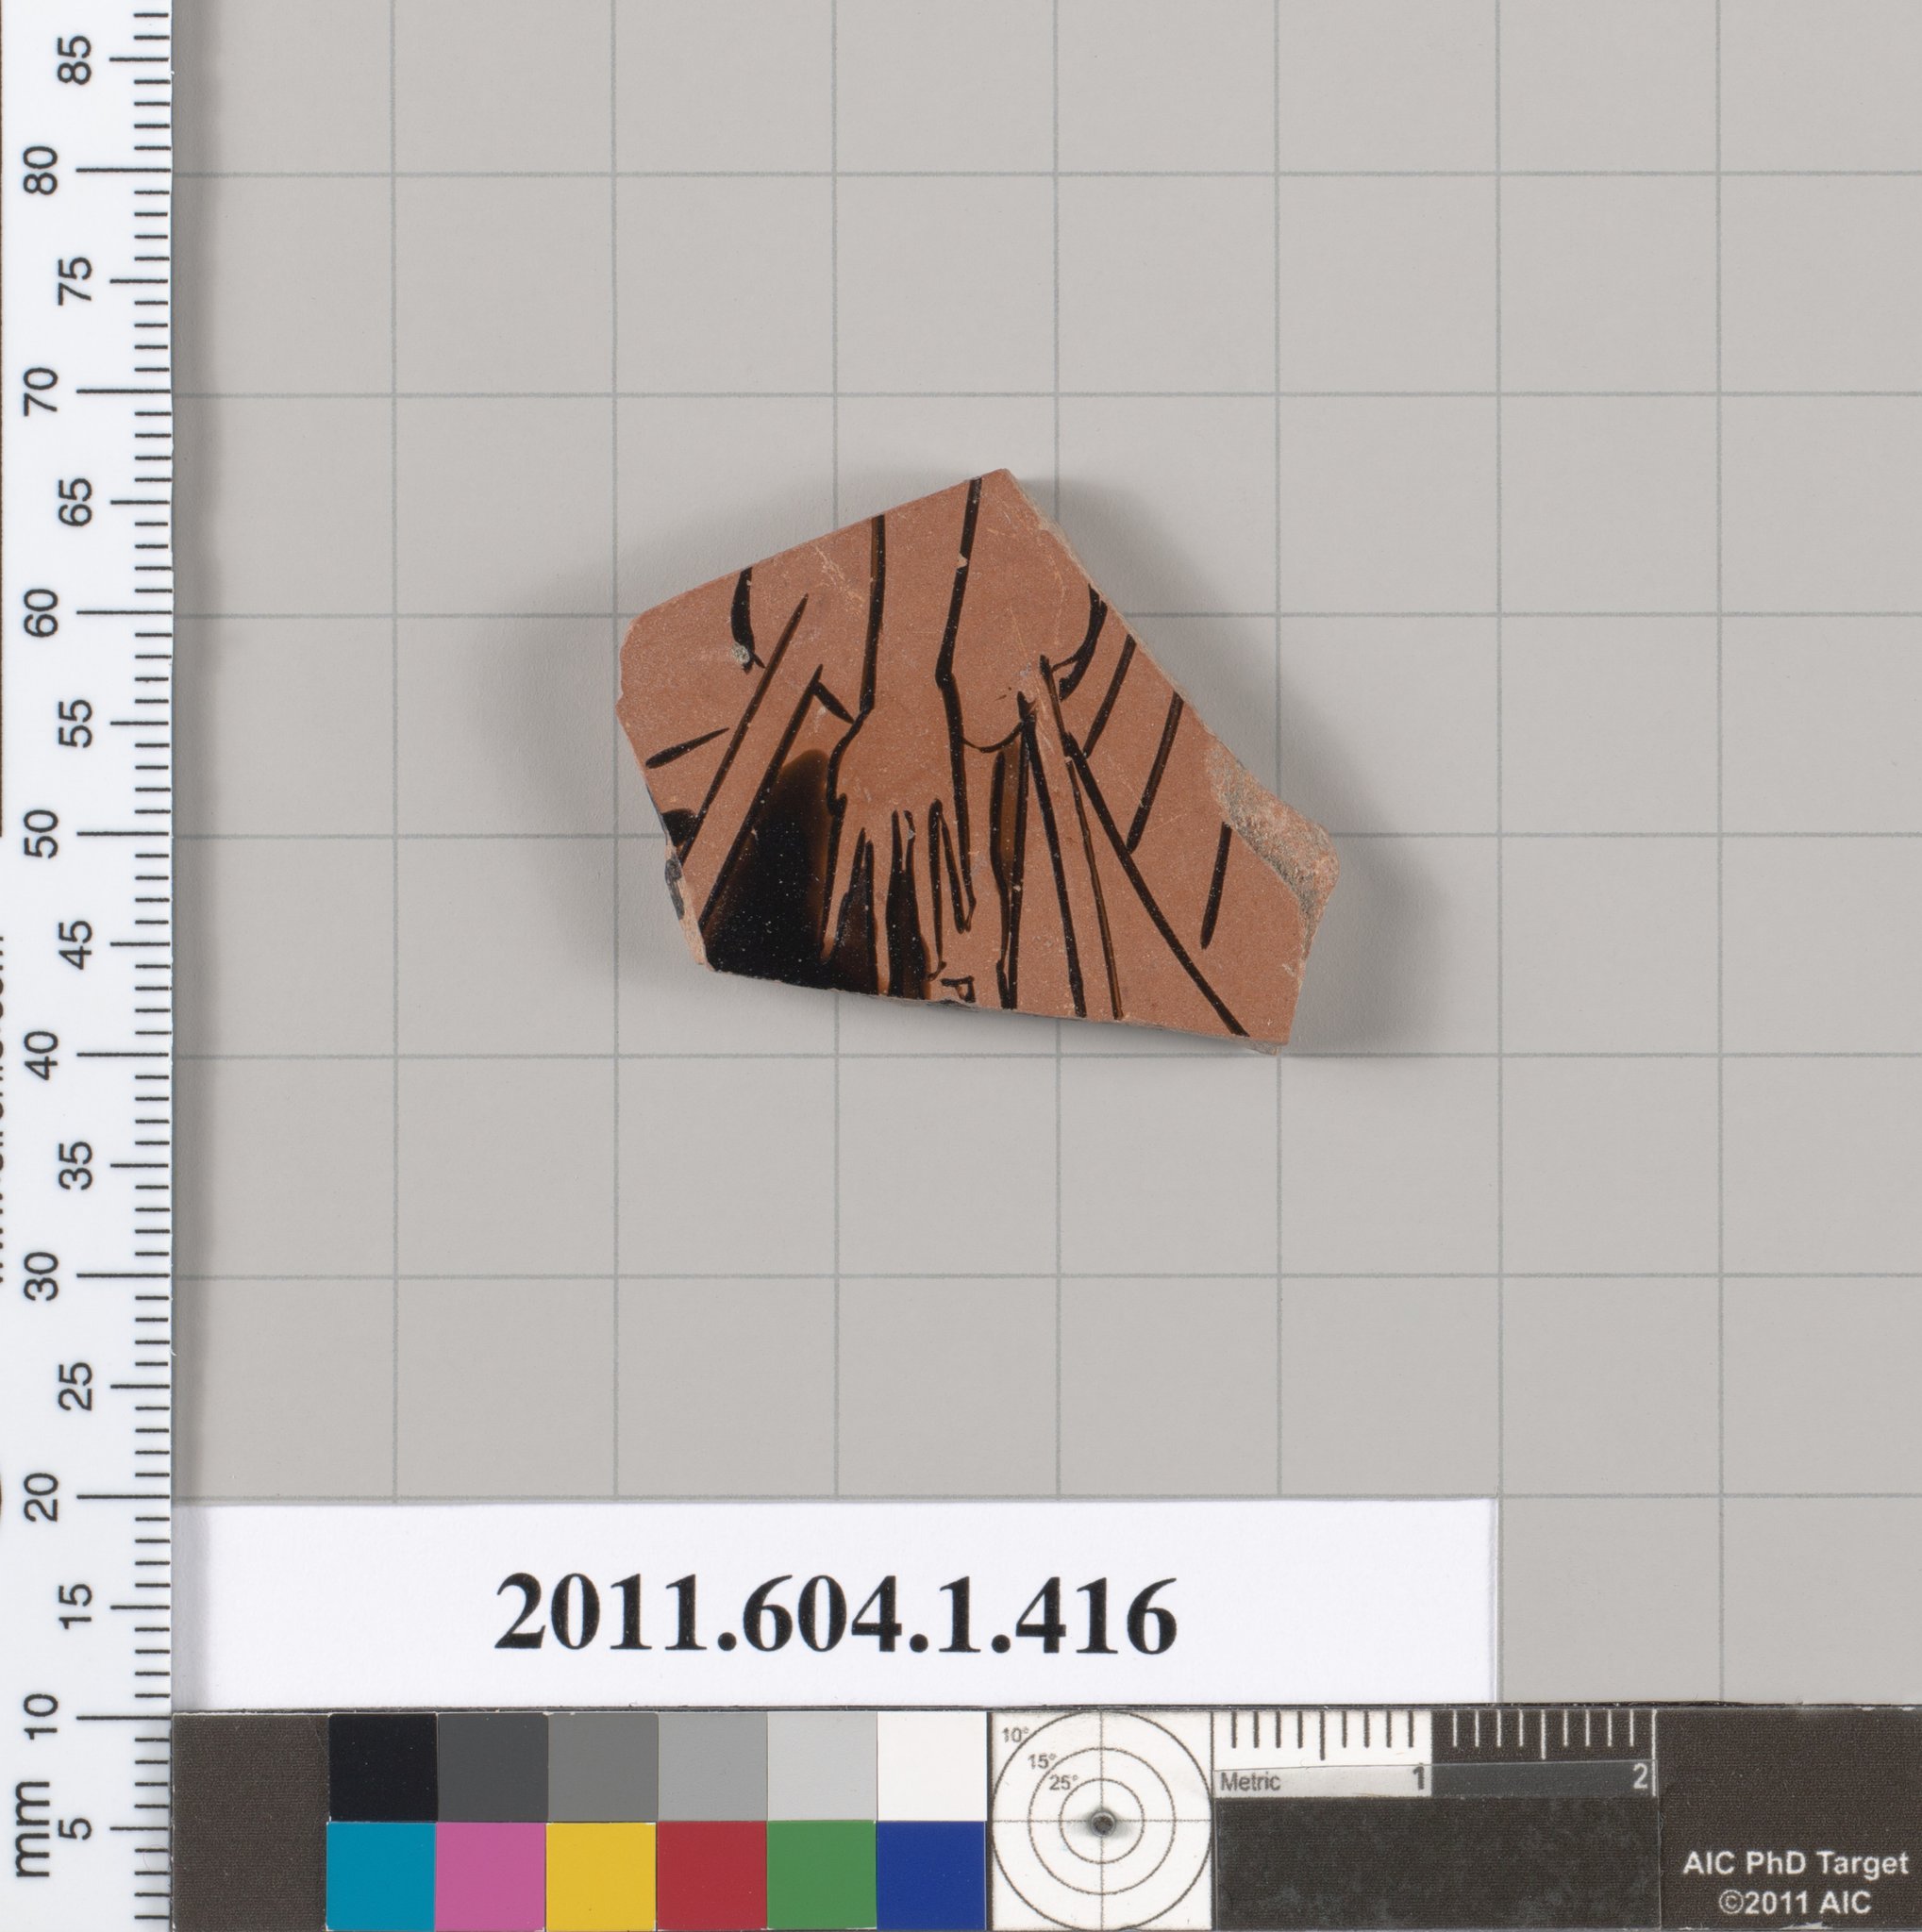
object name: kylix fragment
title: Terracotta fragment of a kylix (drinking cup)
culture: greek, attic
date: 475-451 BCE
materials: terracotta